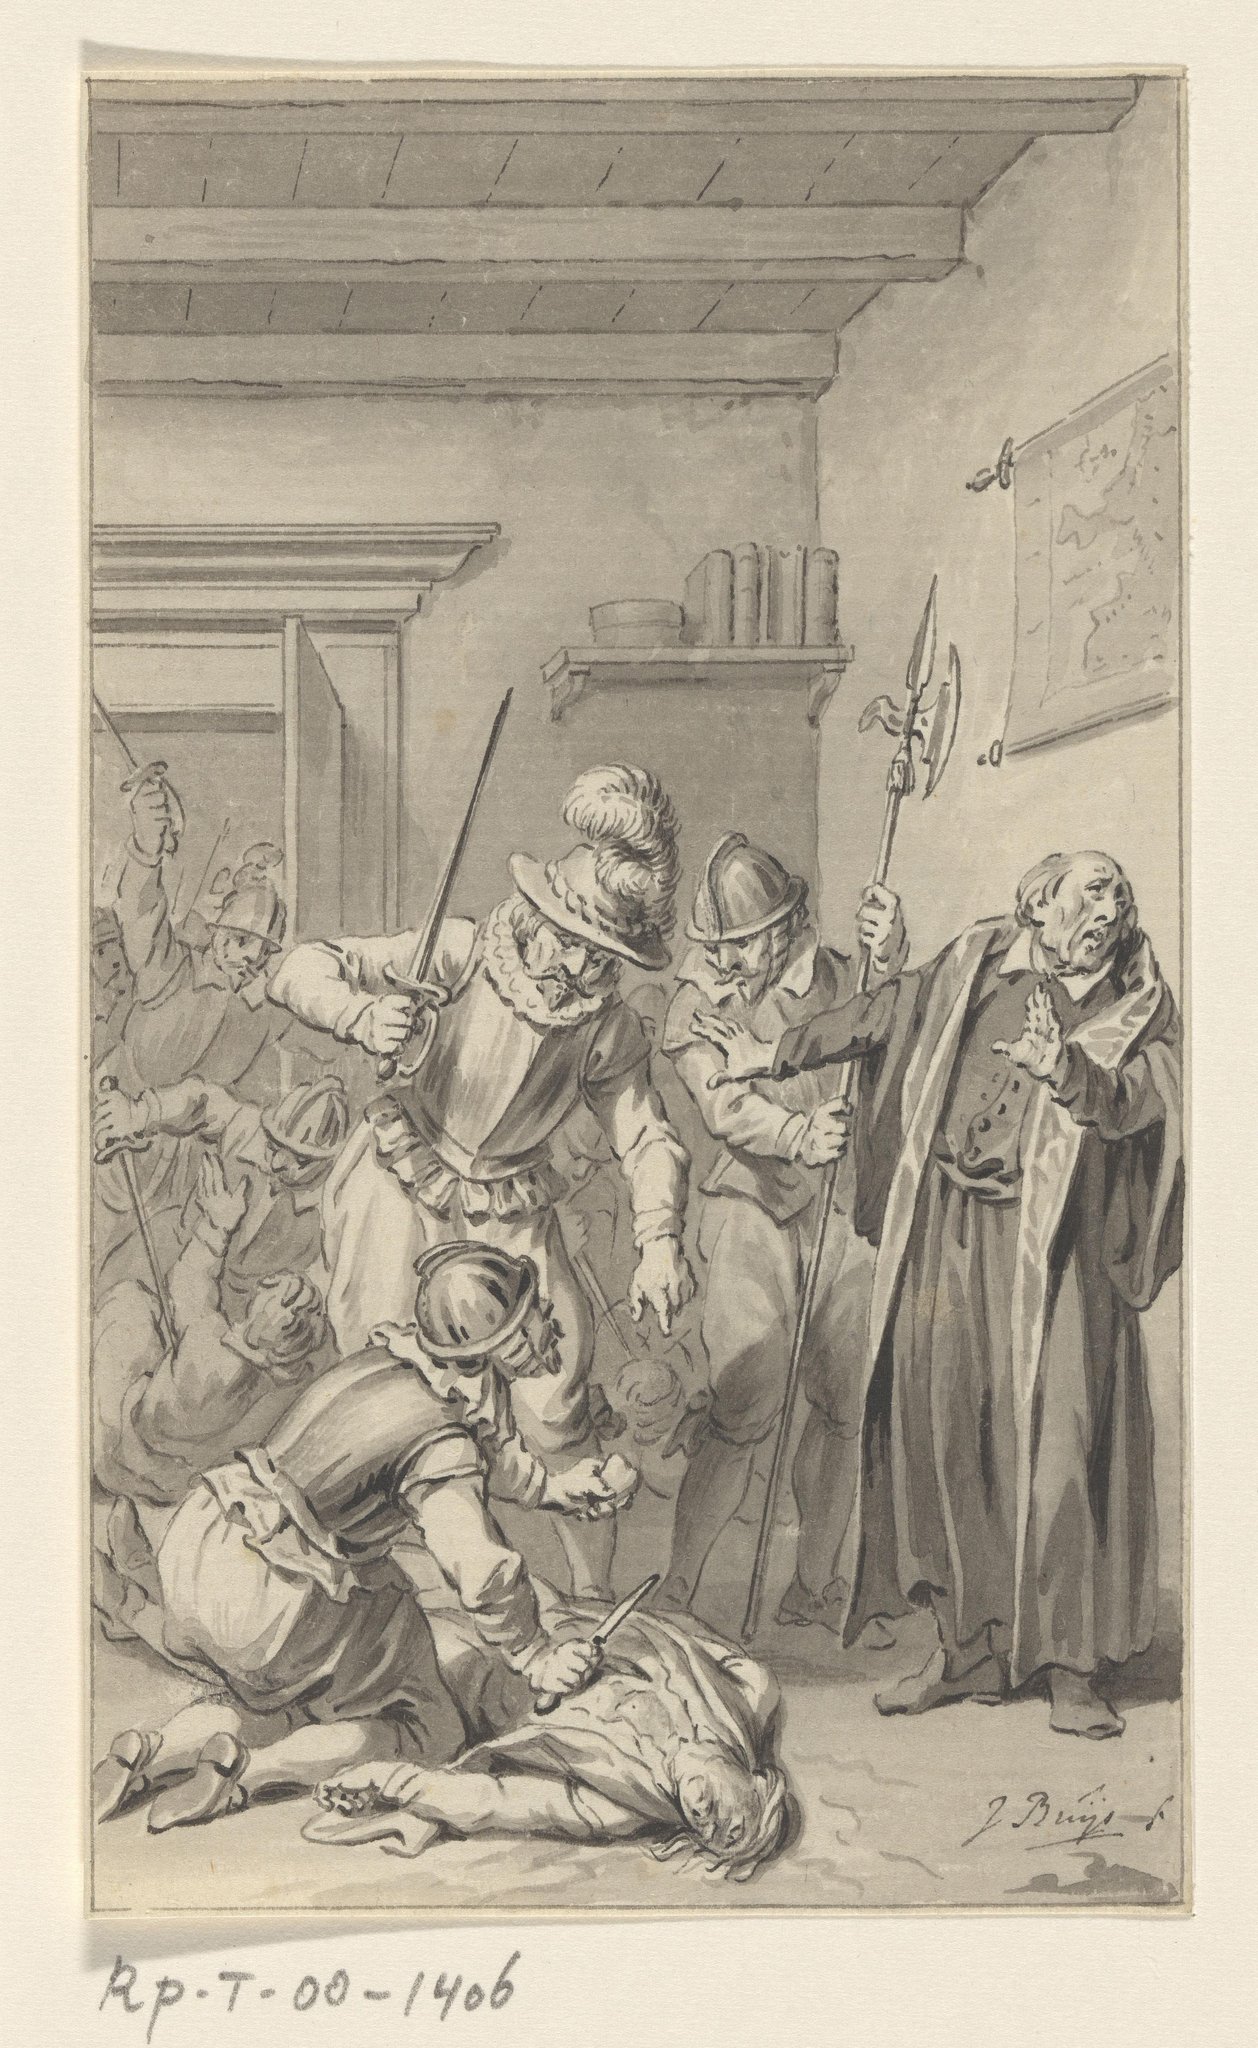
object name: history print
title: Mishandeling van de zoon van de geleerde Hortensius door de Spanjaarden te Naarden, 1 december 1572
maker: jacobus buys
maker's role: draughtsman, print maker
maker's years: 1724-1801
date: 1788-1790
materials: ink, paper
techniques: brush, pen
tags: priest, historical persons, torture, mutilation of the corpse, massacre ~ war, historical events and situations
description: De Spanjaarden doden en snijden het hart uit het lichaam van Augustinus Hortensius, de zoon van Lambertus Hortensius, rector en geschiedschrijver te Naarden, 1 december 1572. Ontwerp voor een prent.